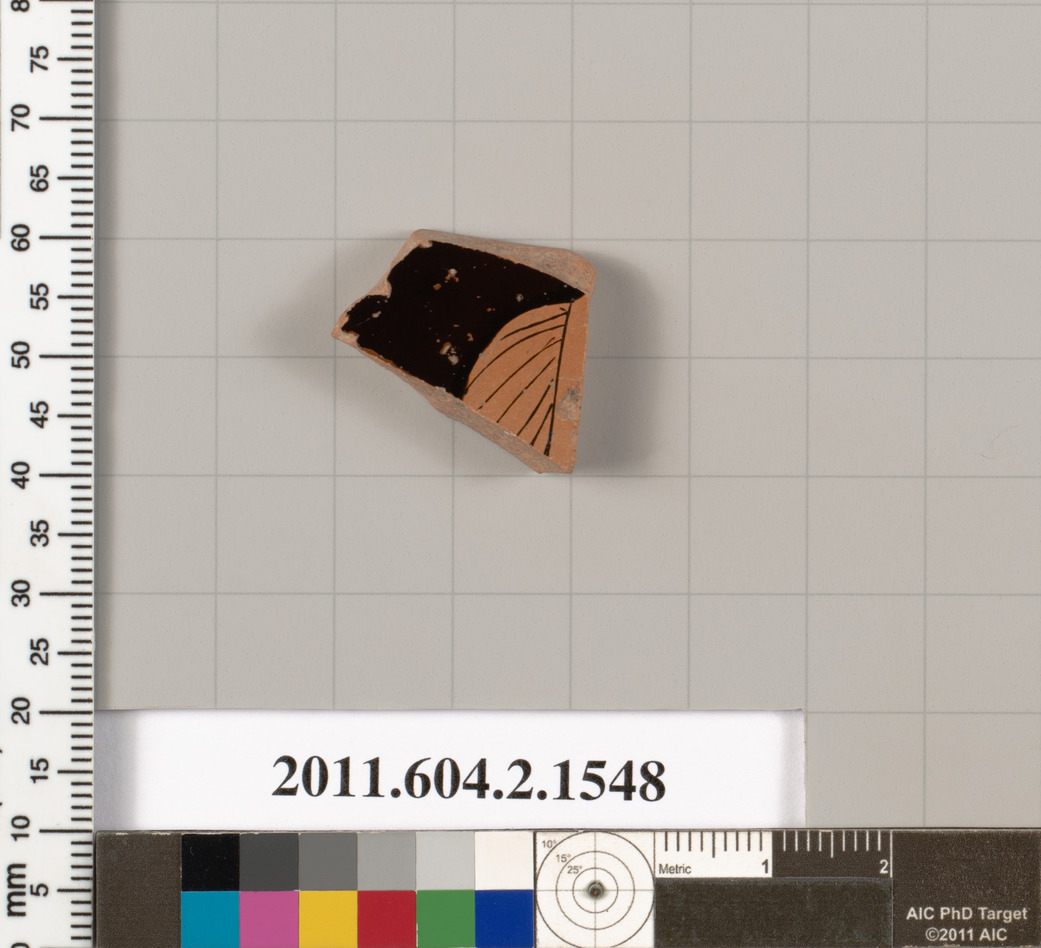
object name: skyphos fragment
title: Terracotta fragment of a skyphos (deep drinking cup)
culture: greek, attic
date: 460-440 BCE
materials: terracotta